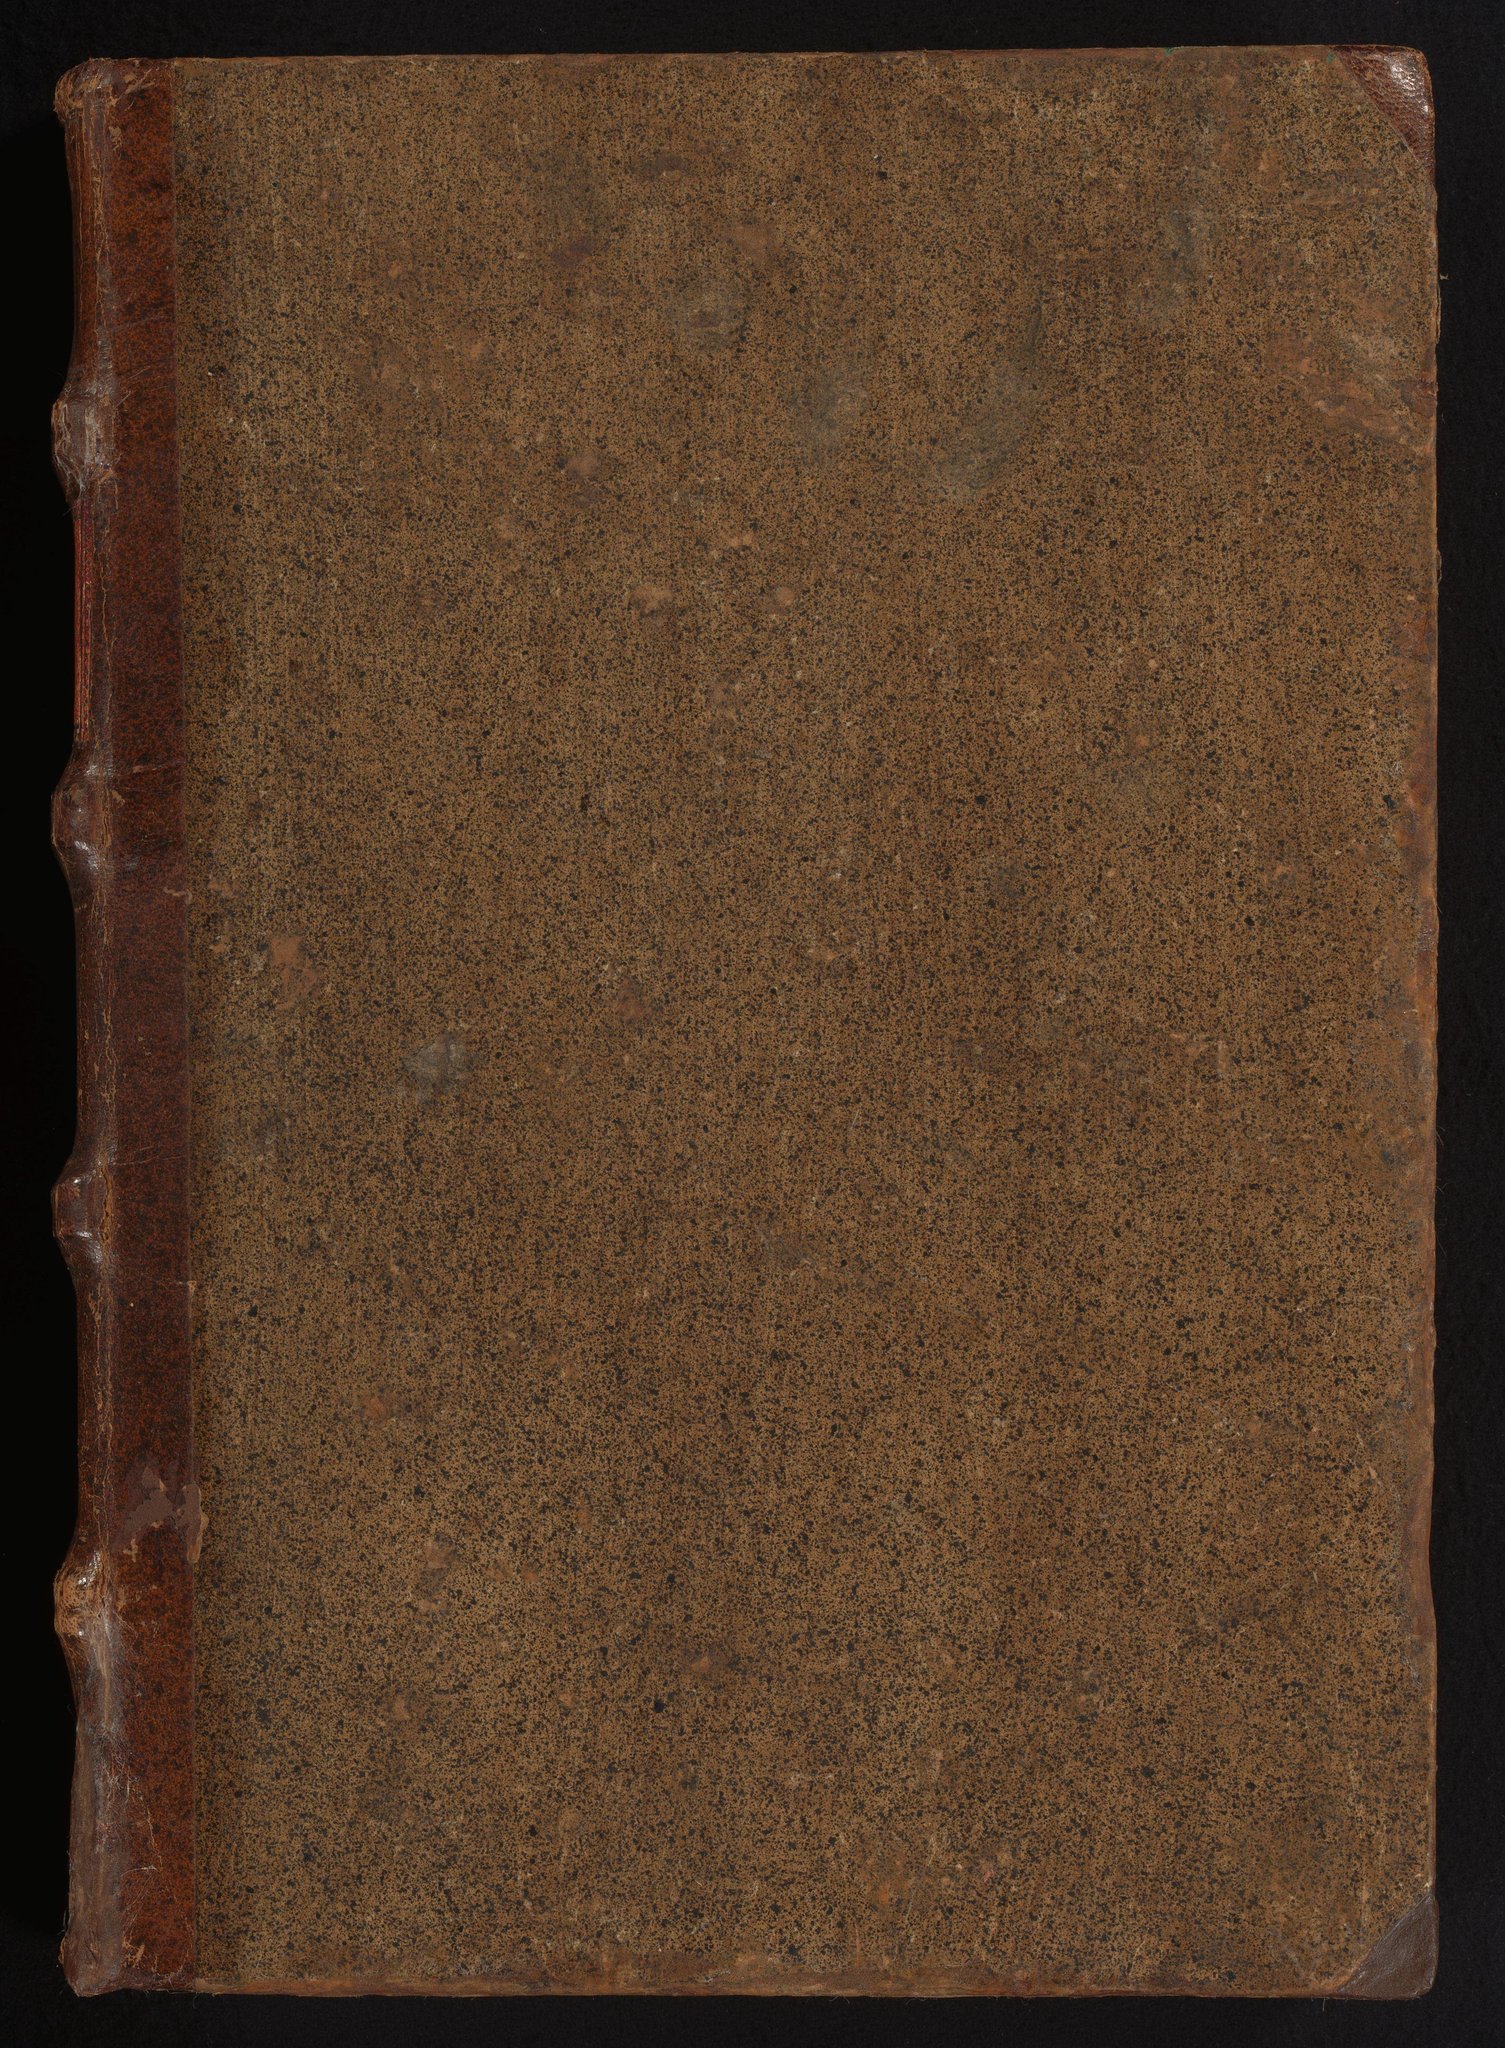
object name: missal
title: Missaal Pataviense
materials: paper, parchment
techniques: hand coloring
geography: vienna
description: Missaal met ingekleurde houtsneden. Uitgegeven in Wenen in 1503.